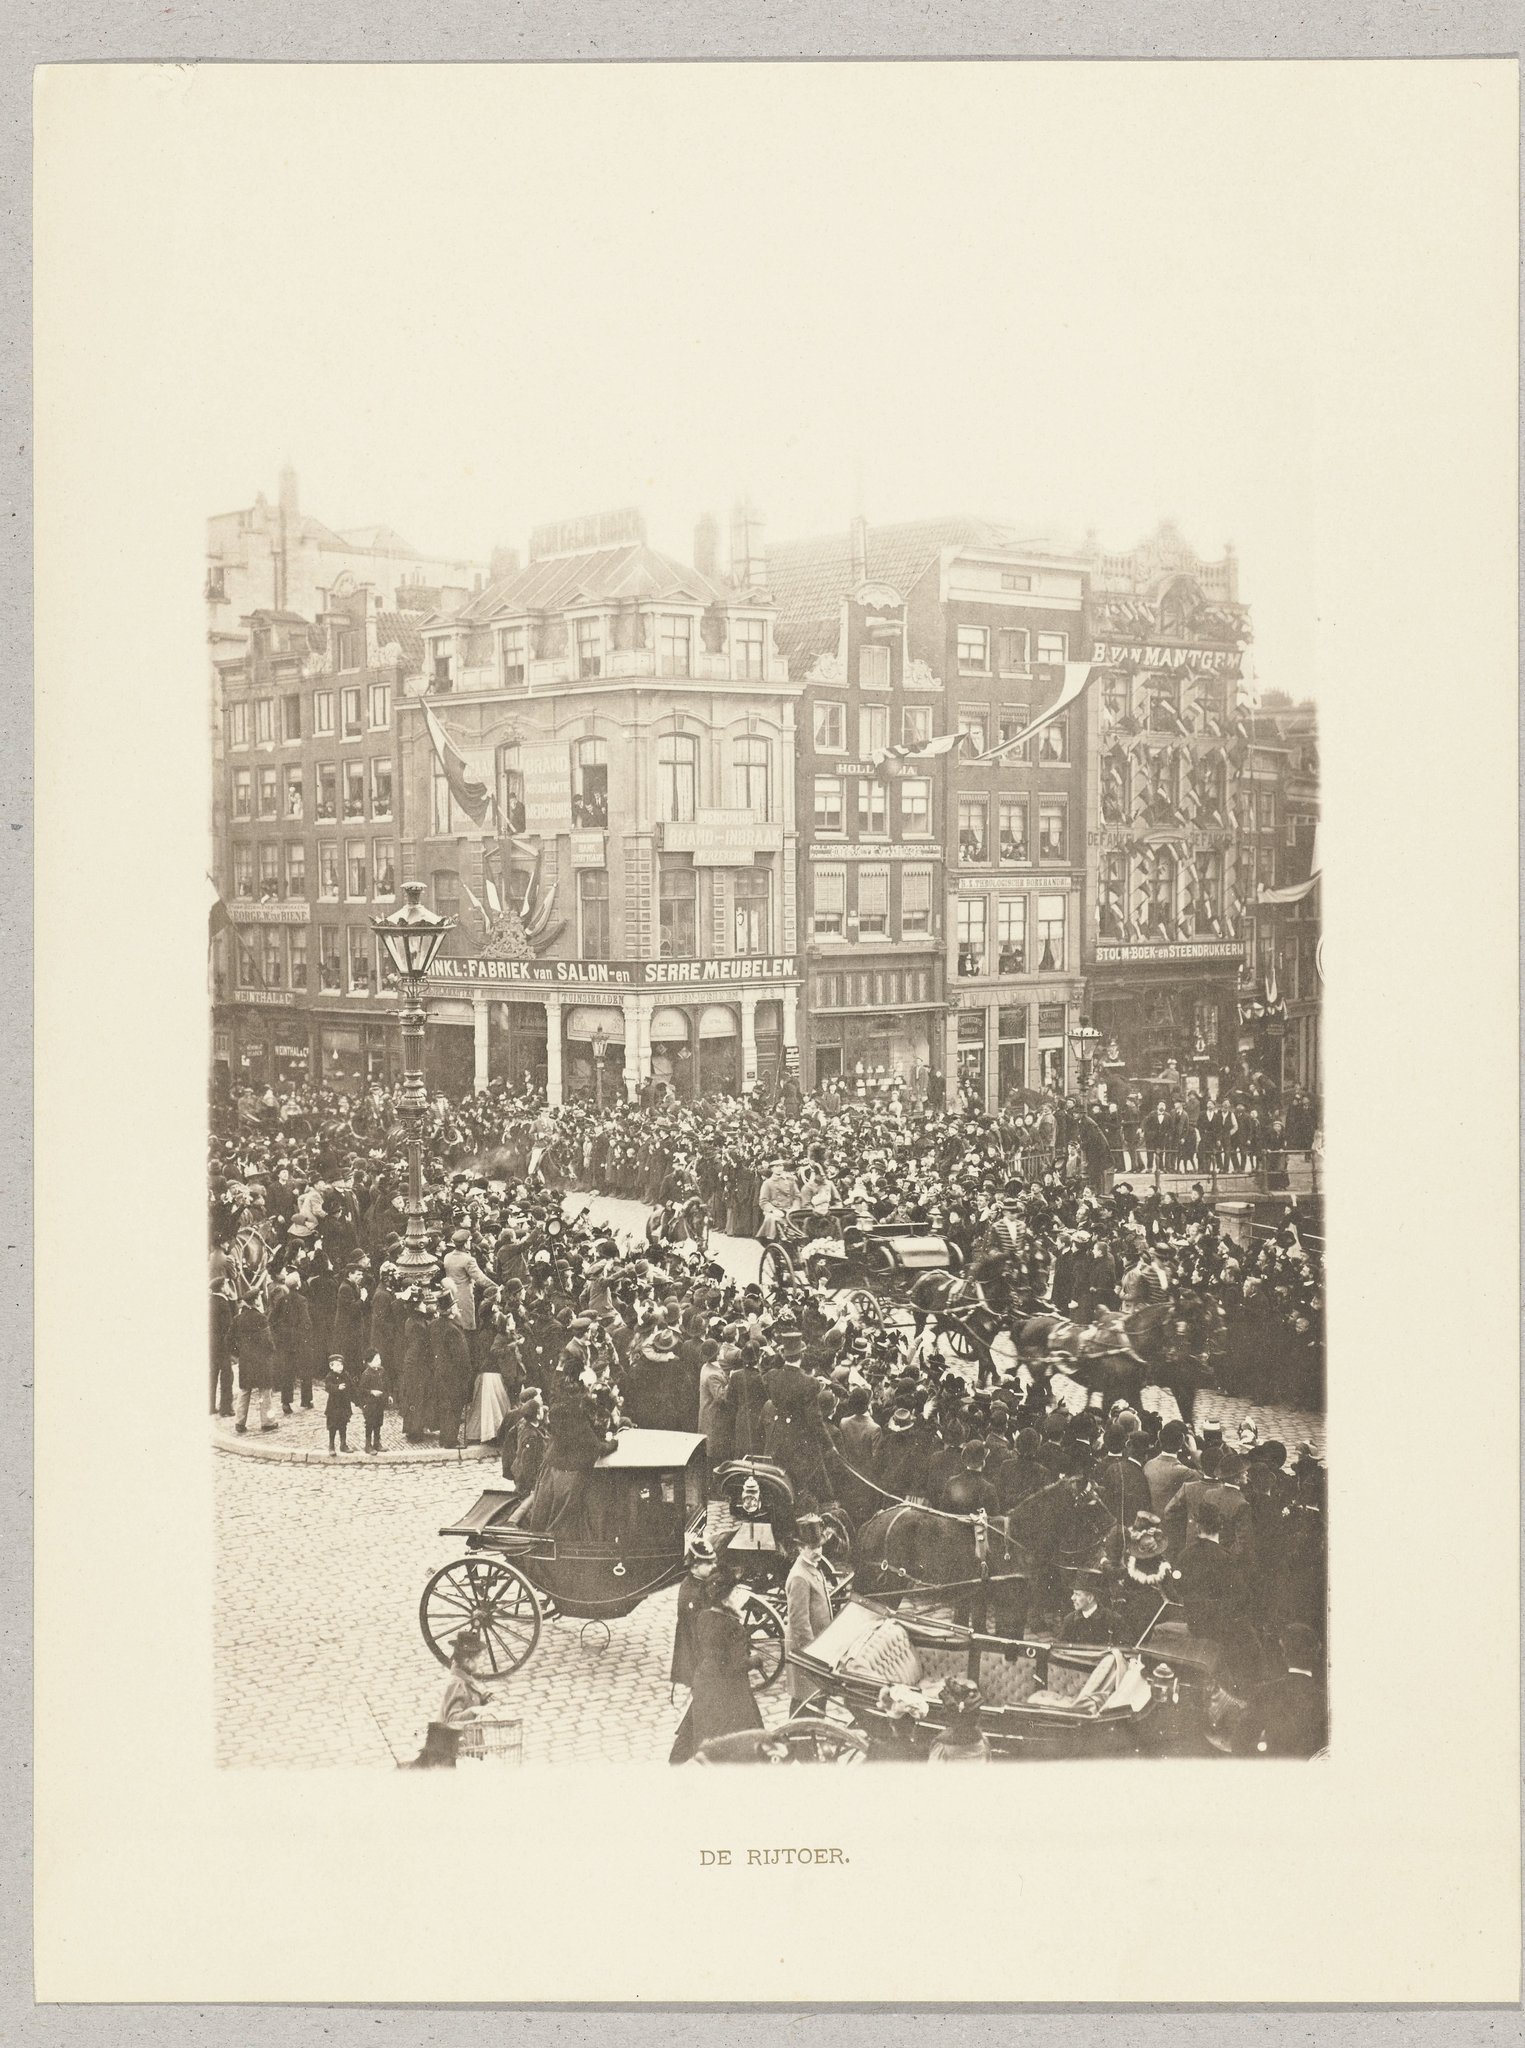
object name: photograph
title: Rijtoer door de stad Amsterdam van het koninklijk paar, 5 maart 1901, feestelijkheden ter gelegenheid van het huwelijk van koningin Wilhelmina en prins Hendrik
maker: barend groote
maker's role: fotograaf, fotohandel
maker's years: 1862-1946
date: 1901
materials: paper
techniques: photograph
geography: amsterdam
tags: the hague, print maker, wilhelmina of the netherlands, hendrik (prins der nederlanden (1876-1934)), four-wheeled, animal-drawn vehicle, e.g.: cab, carriage, coach, historical events and situations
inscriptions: annotation: ‘De rijtoer.’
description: De menigte staat op het Muntplein te Amsterdam.